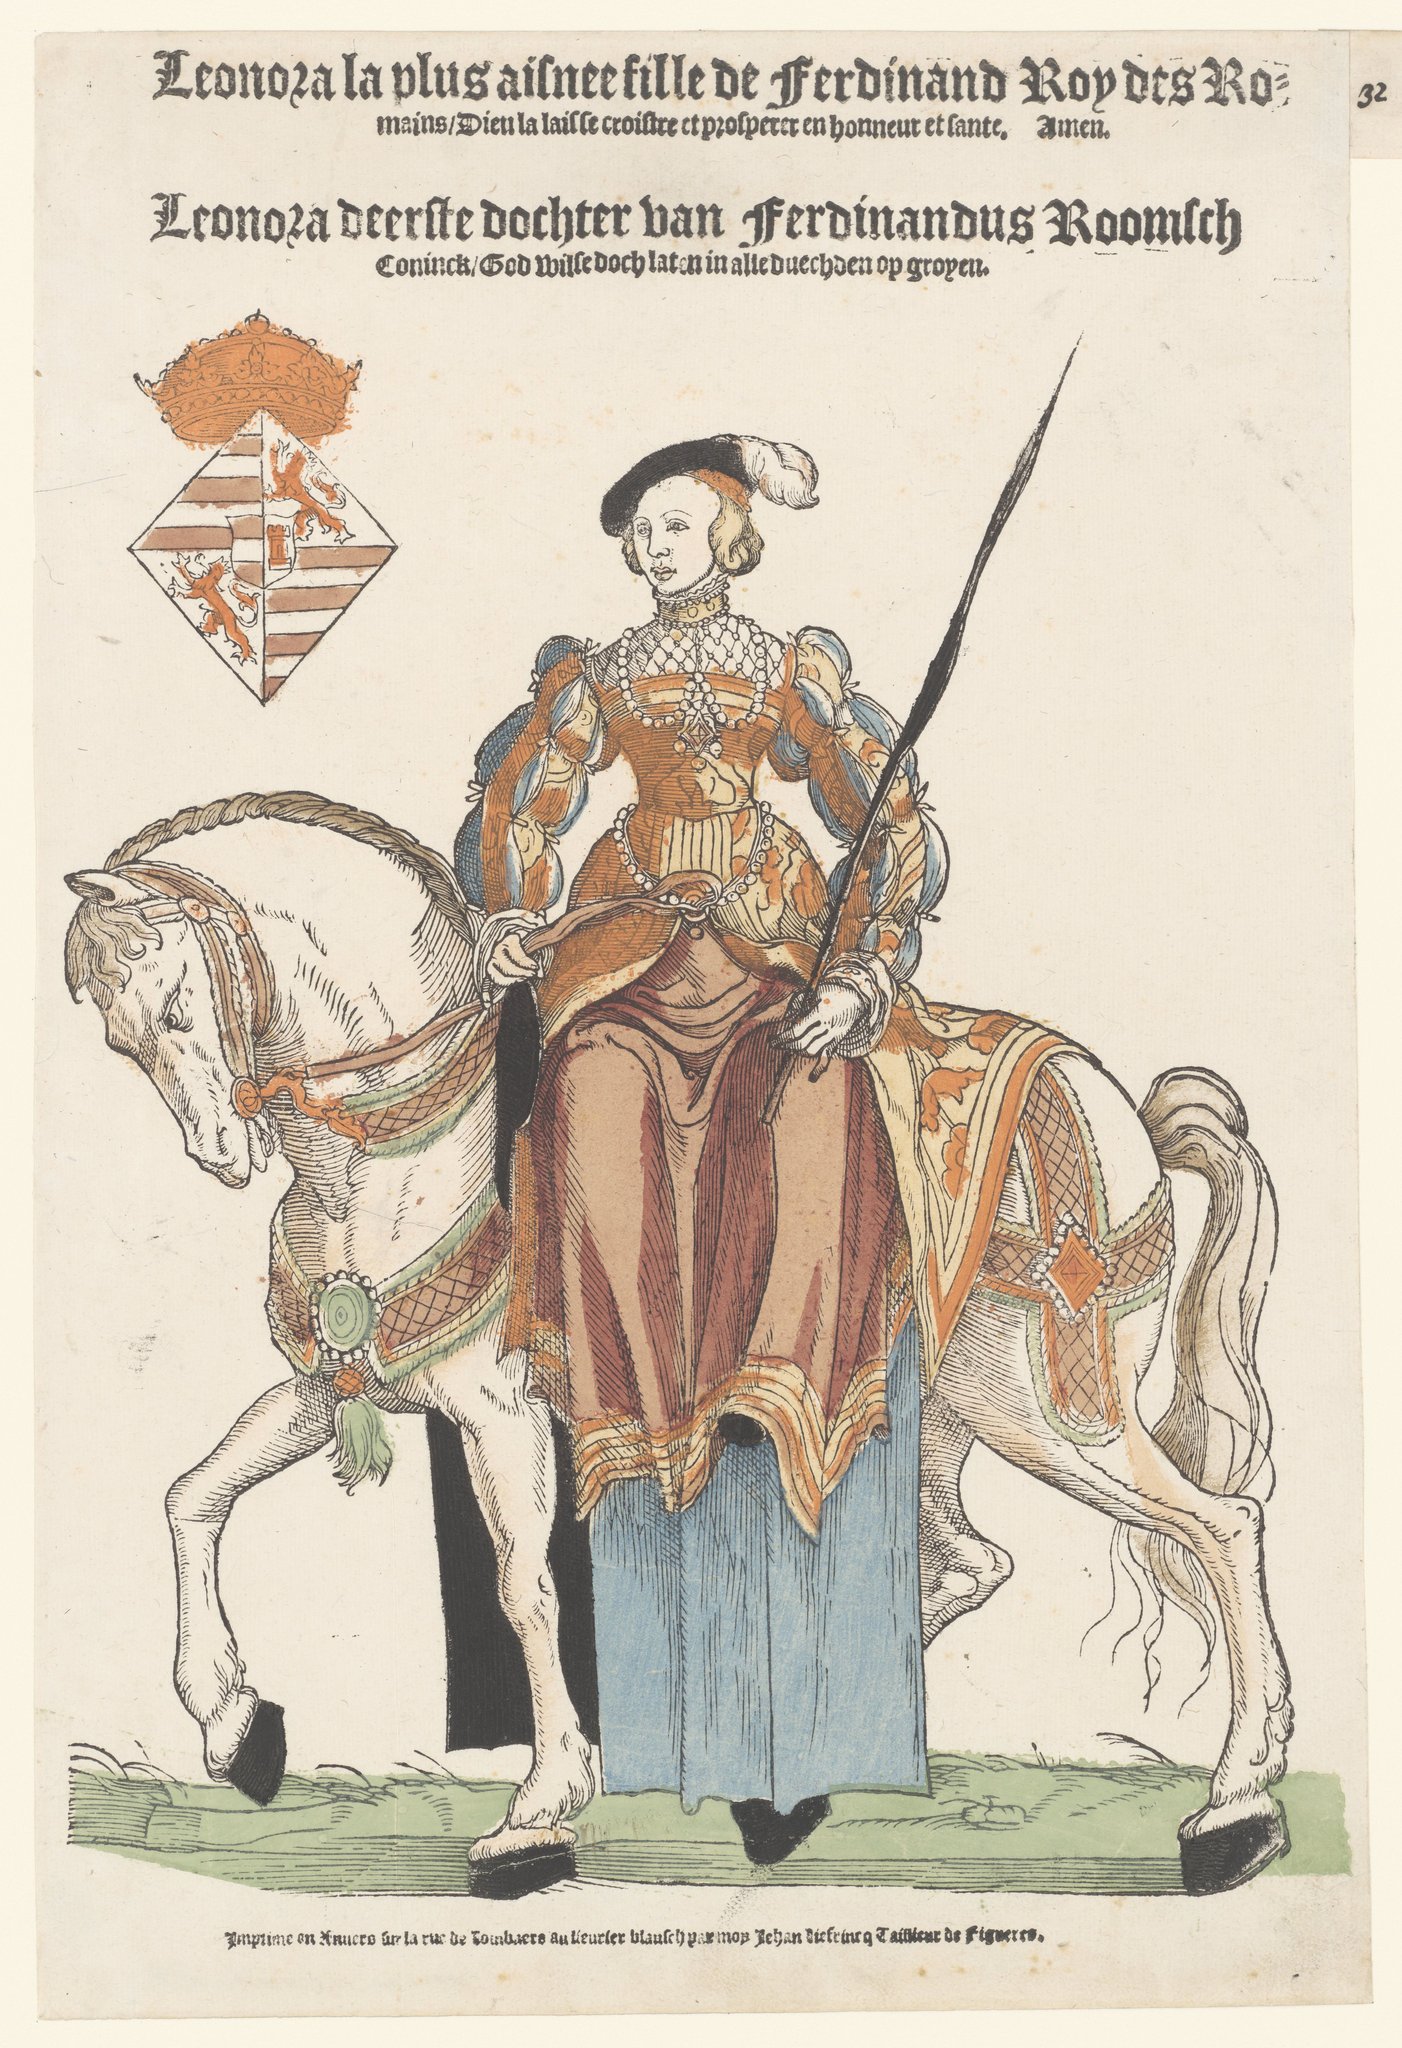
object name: print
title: Portret van Eleonora van Oostenrijk te paard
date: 1539-1561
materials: paper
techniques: hand coloring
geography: antwerp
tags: brussels, eleonora van oostenrijk (koningin van portugal en frankrijk), equestrian state-portrait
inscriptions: number: ‘32’, address: ‘Imprime en Anvers sur la rue de Lombaers au lieurier blausch par moy Jehan Liefrincq Tailleur de Figueres’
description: Eleonora van Oostenrijk in dameszit te paard, linksboven haar wapen, ruitvormig.